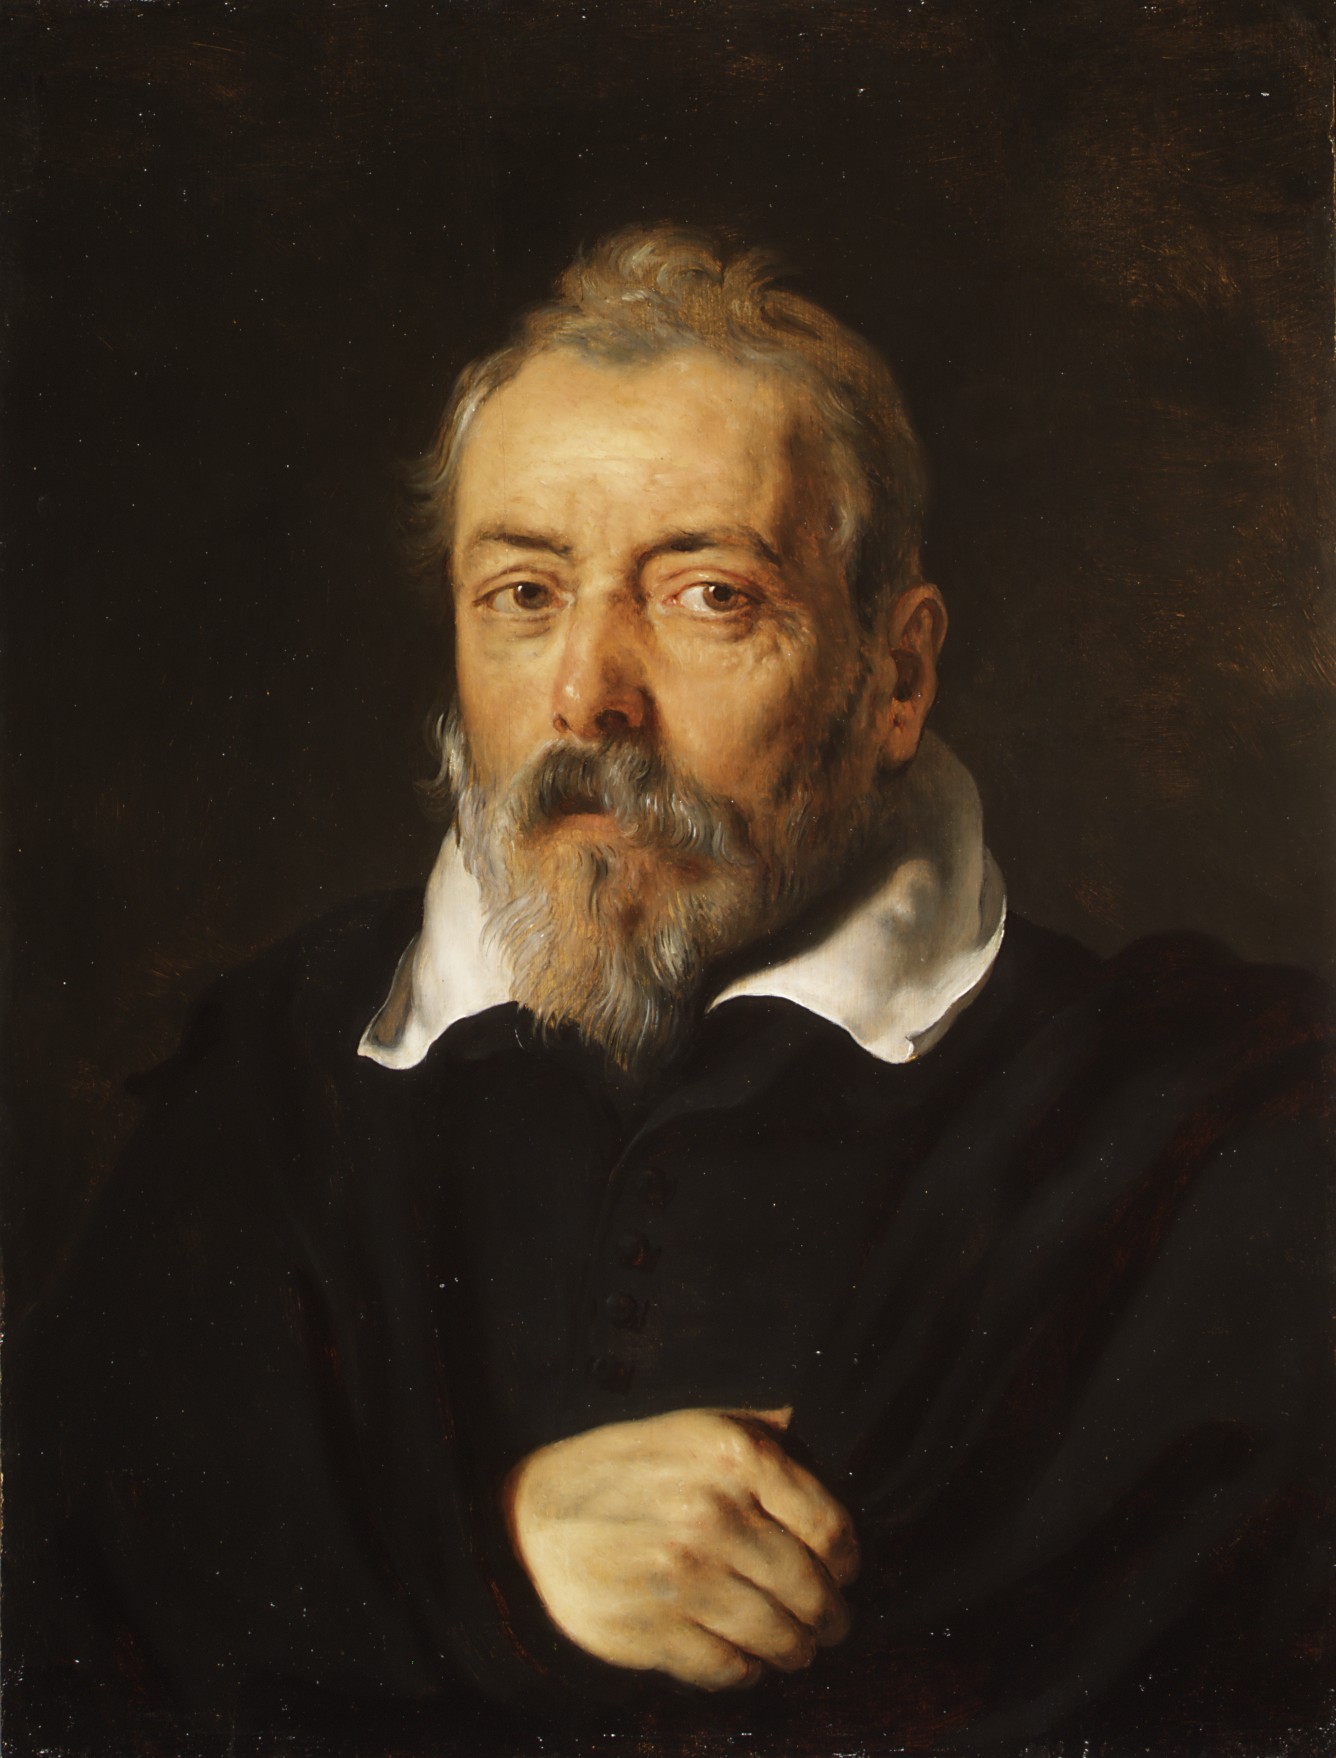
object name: painting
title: Frans Francken I (1542–1616)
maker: peter paul rubens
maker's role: artist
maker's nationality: flemish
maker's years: 1577-1640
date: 1597-1640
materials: oil, wood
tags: men,portraits,artists